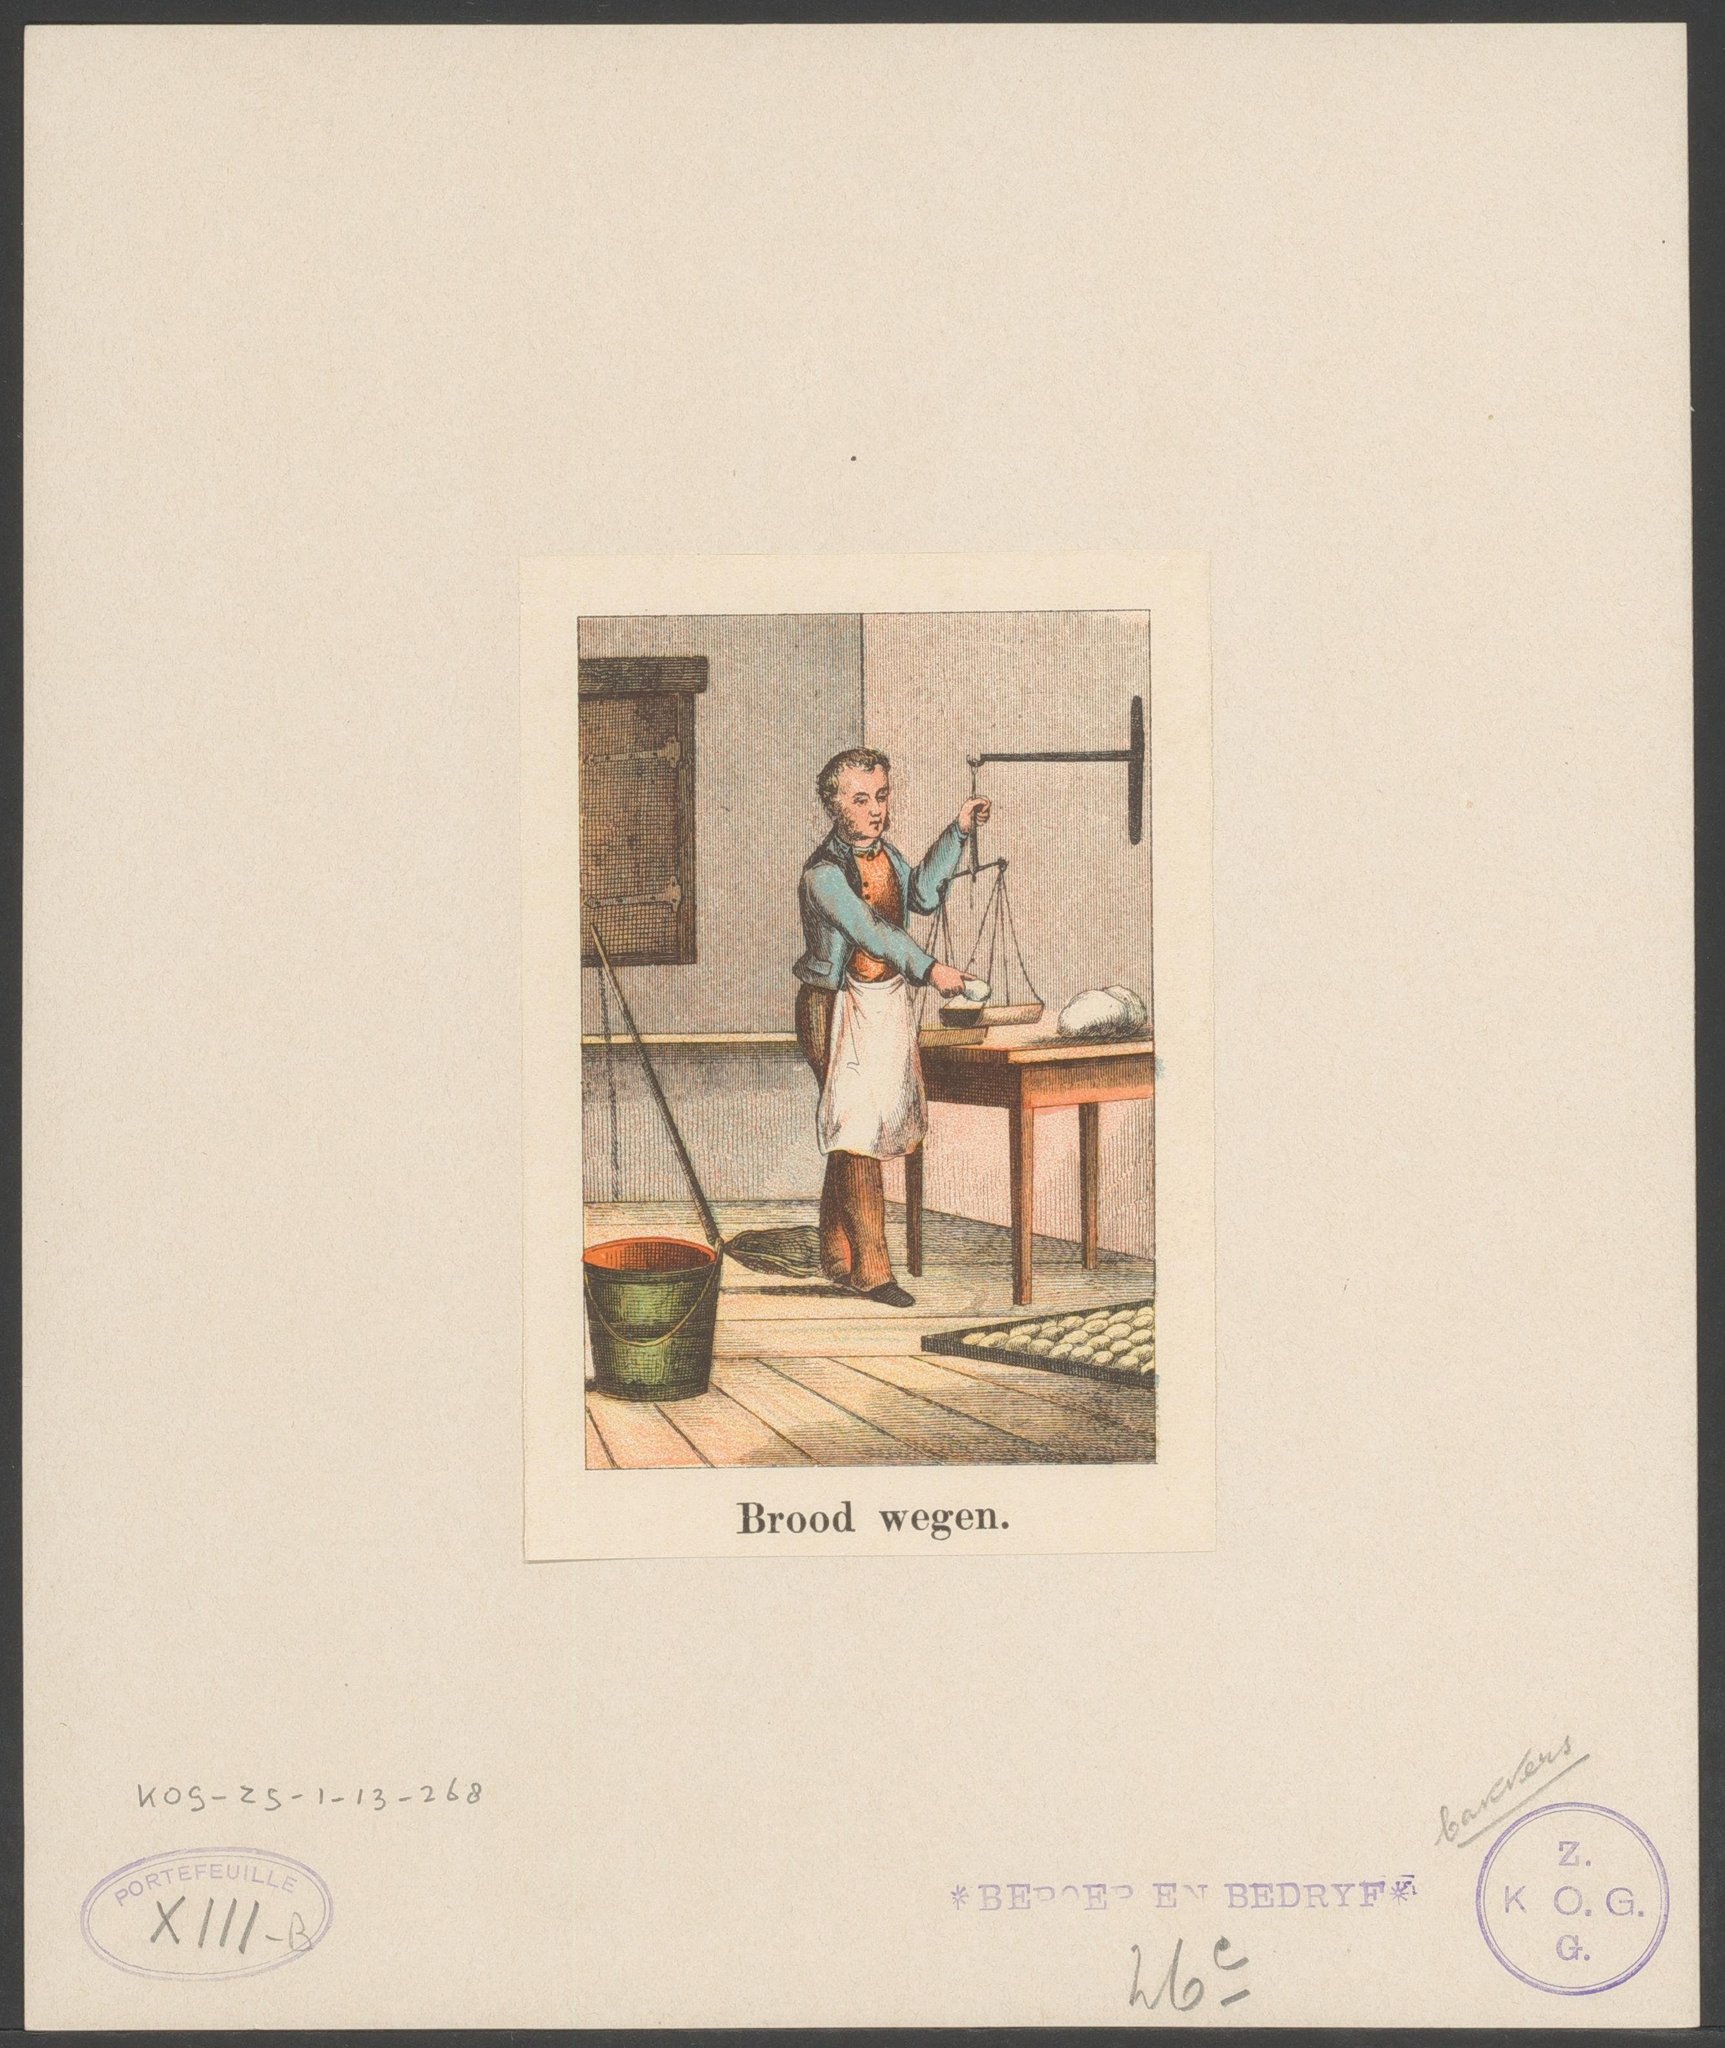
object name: popular print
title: Brood wegen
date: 1865-1872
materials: paper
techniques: lithograph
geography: amsterdam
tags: baker (+ labourers ~ crafts, industries, agriculture), baker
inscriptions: stamp, stamp, collector's mark: Lugt 1641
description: Onderwerpsrubrieken binnen de Atlas Zeden en Gewoonten: Handel, Nijverheid en Verkeer, Beroep en bedrijf, Mannelijk, Eet- en drinkwaren.